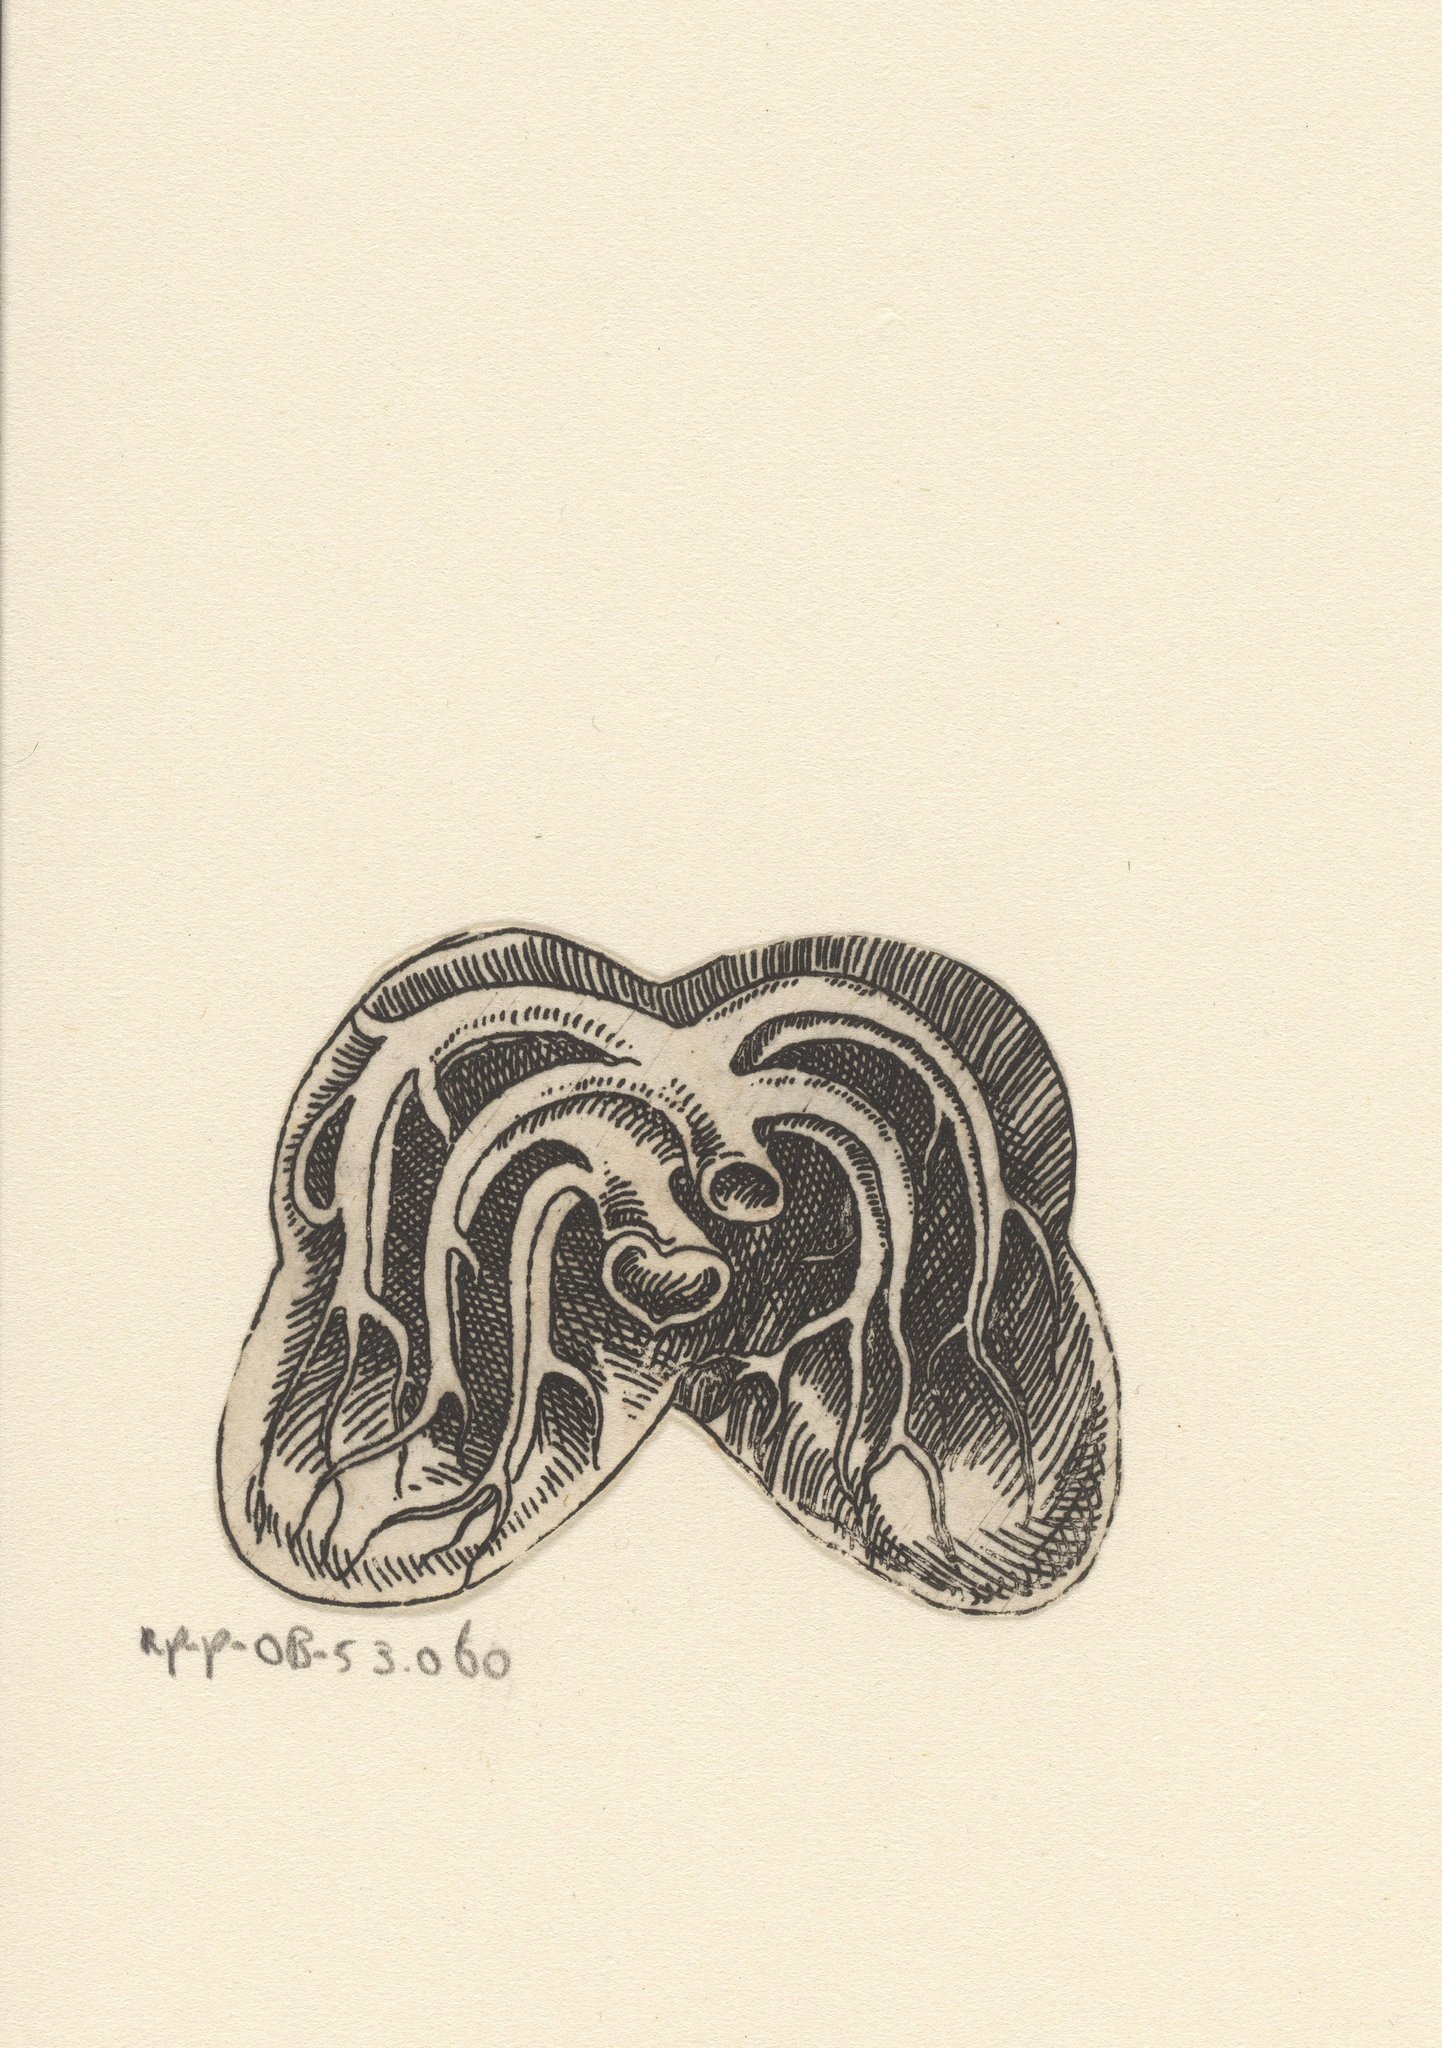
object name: print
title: Dwarsdoorsnede longen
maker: lucas kilian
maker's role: draughtsman, print maker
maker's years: 1579-1637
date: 1589-1637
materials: paper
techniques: etching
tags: lungs, bronchia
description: Suzanne Karr Schmidt suggereert dat deze prenten van losse en uitneembare (dus niet geplakte) organen onderdeel waren van de Visio Secundae en Visio Tertia van Johann Remmelin's 'Catoptrum Microcosmicum' uit 1619.